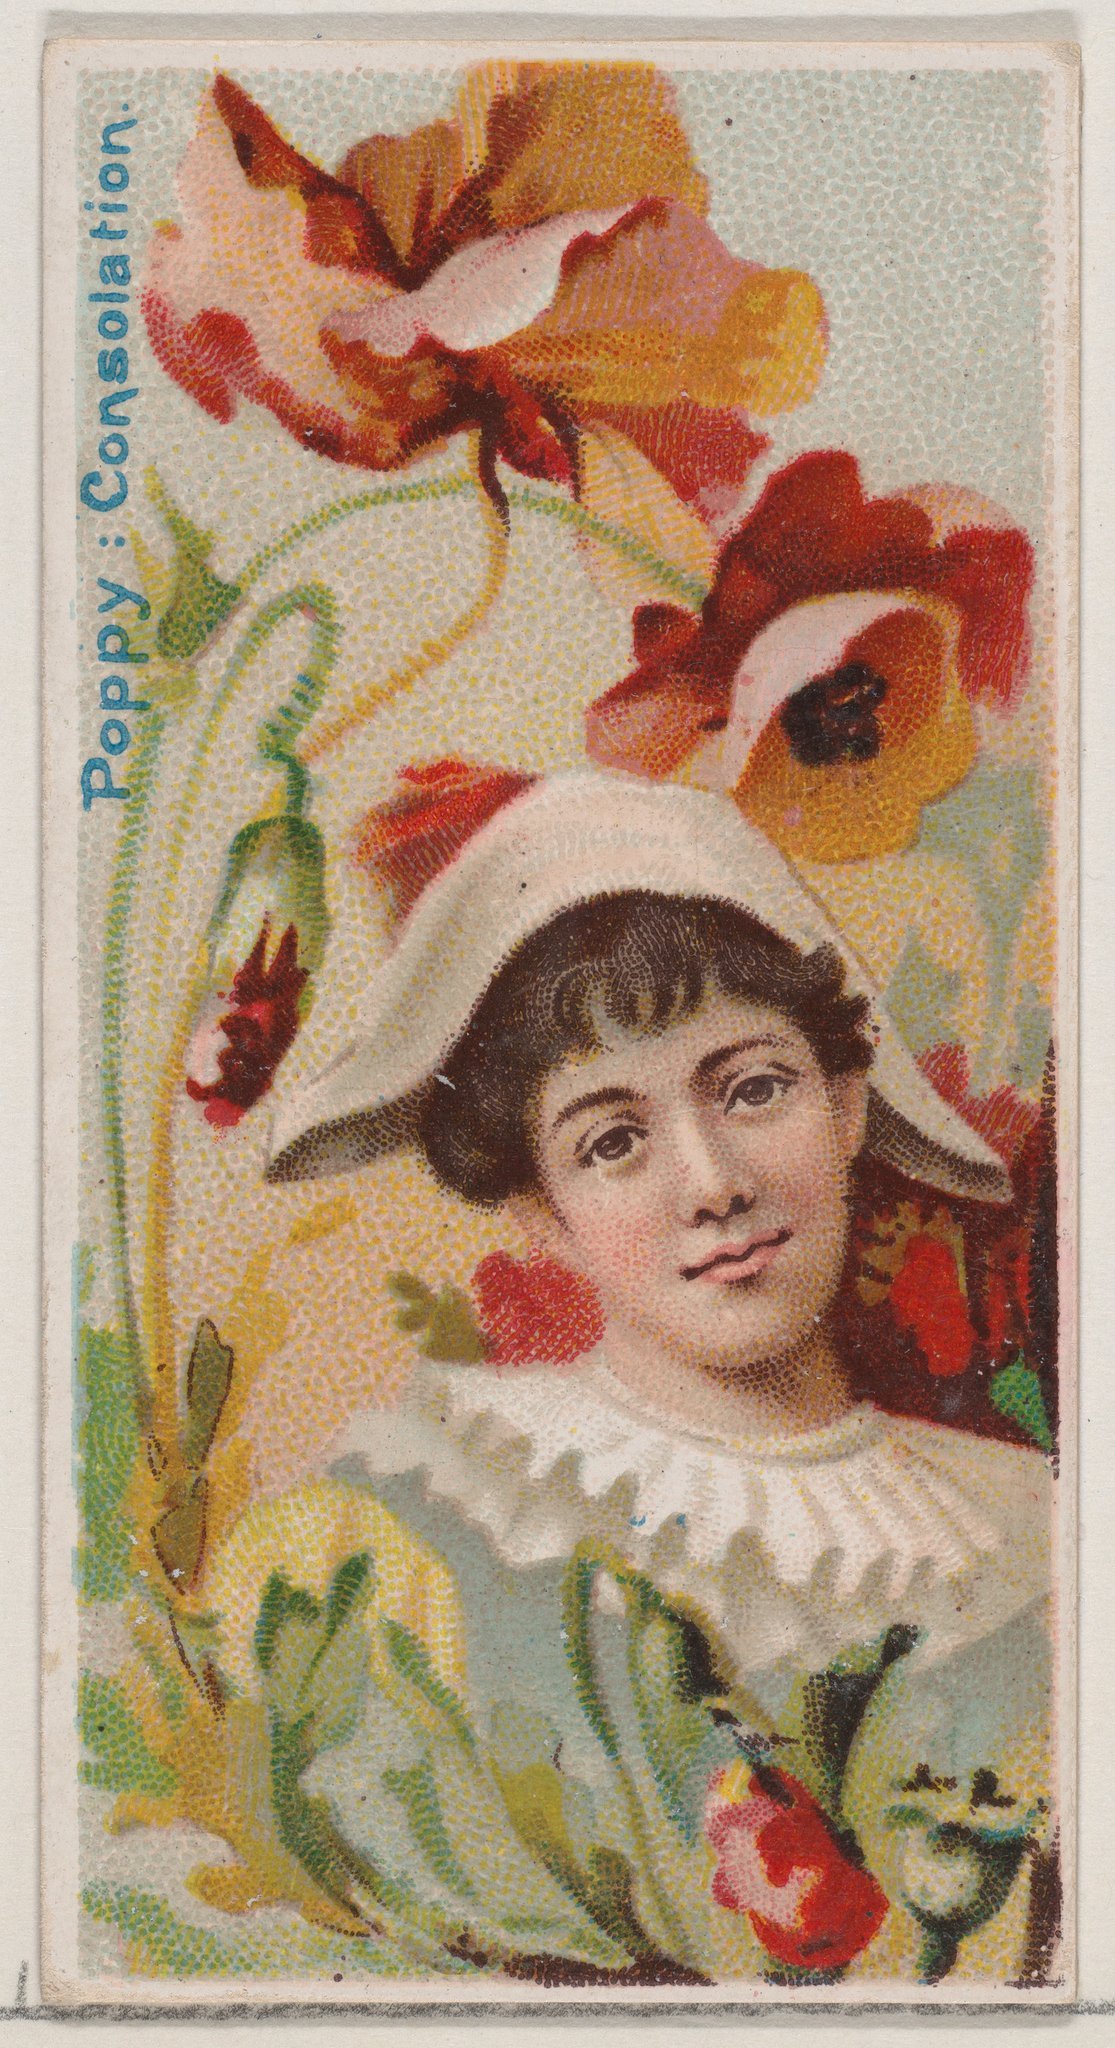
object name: print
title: Poppy: Consolation, from the series Floral Beauties and Language of Flowers (N75) for Duke brand cigarettes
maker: american tobacco company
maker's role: publisher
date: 1892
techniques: color lithograph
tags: women,flowers